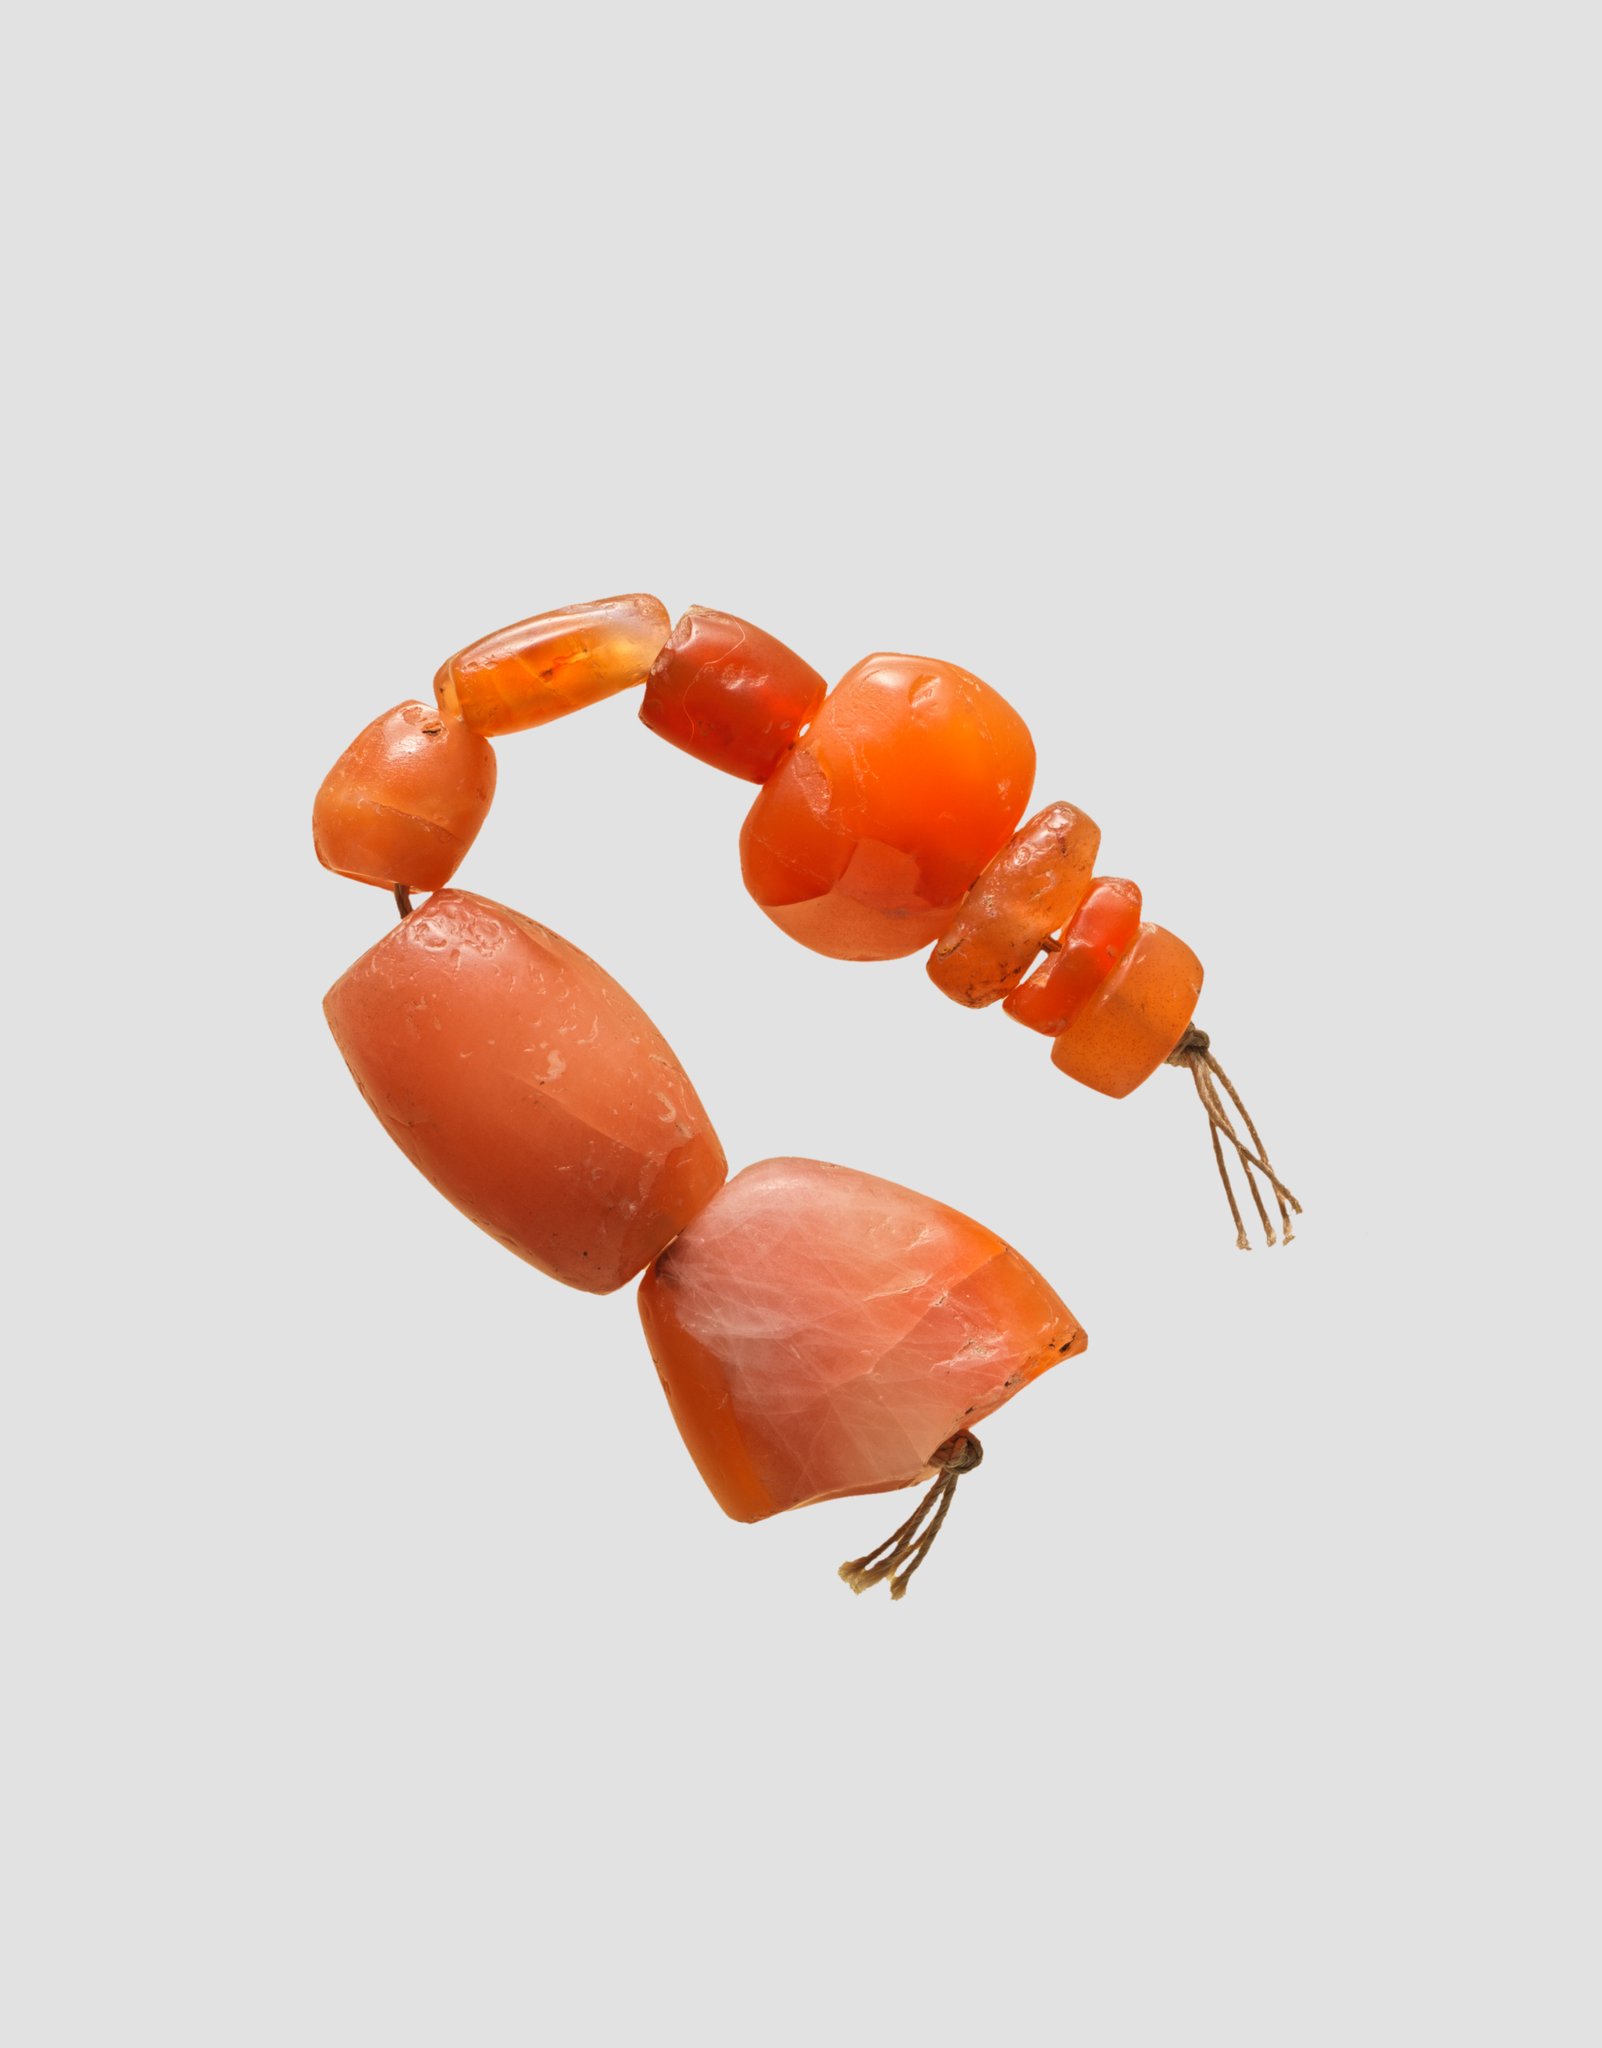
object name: bead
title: Beads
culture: iranian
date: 900-801 BCE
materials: gemstone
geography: iran